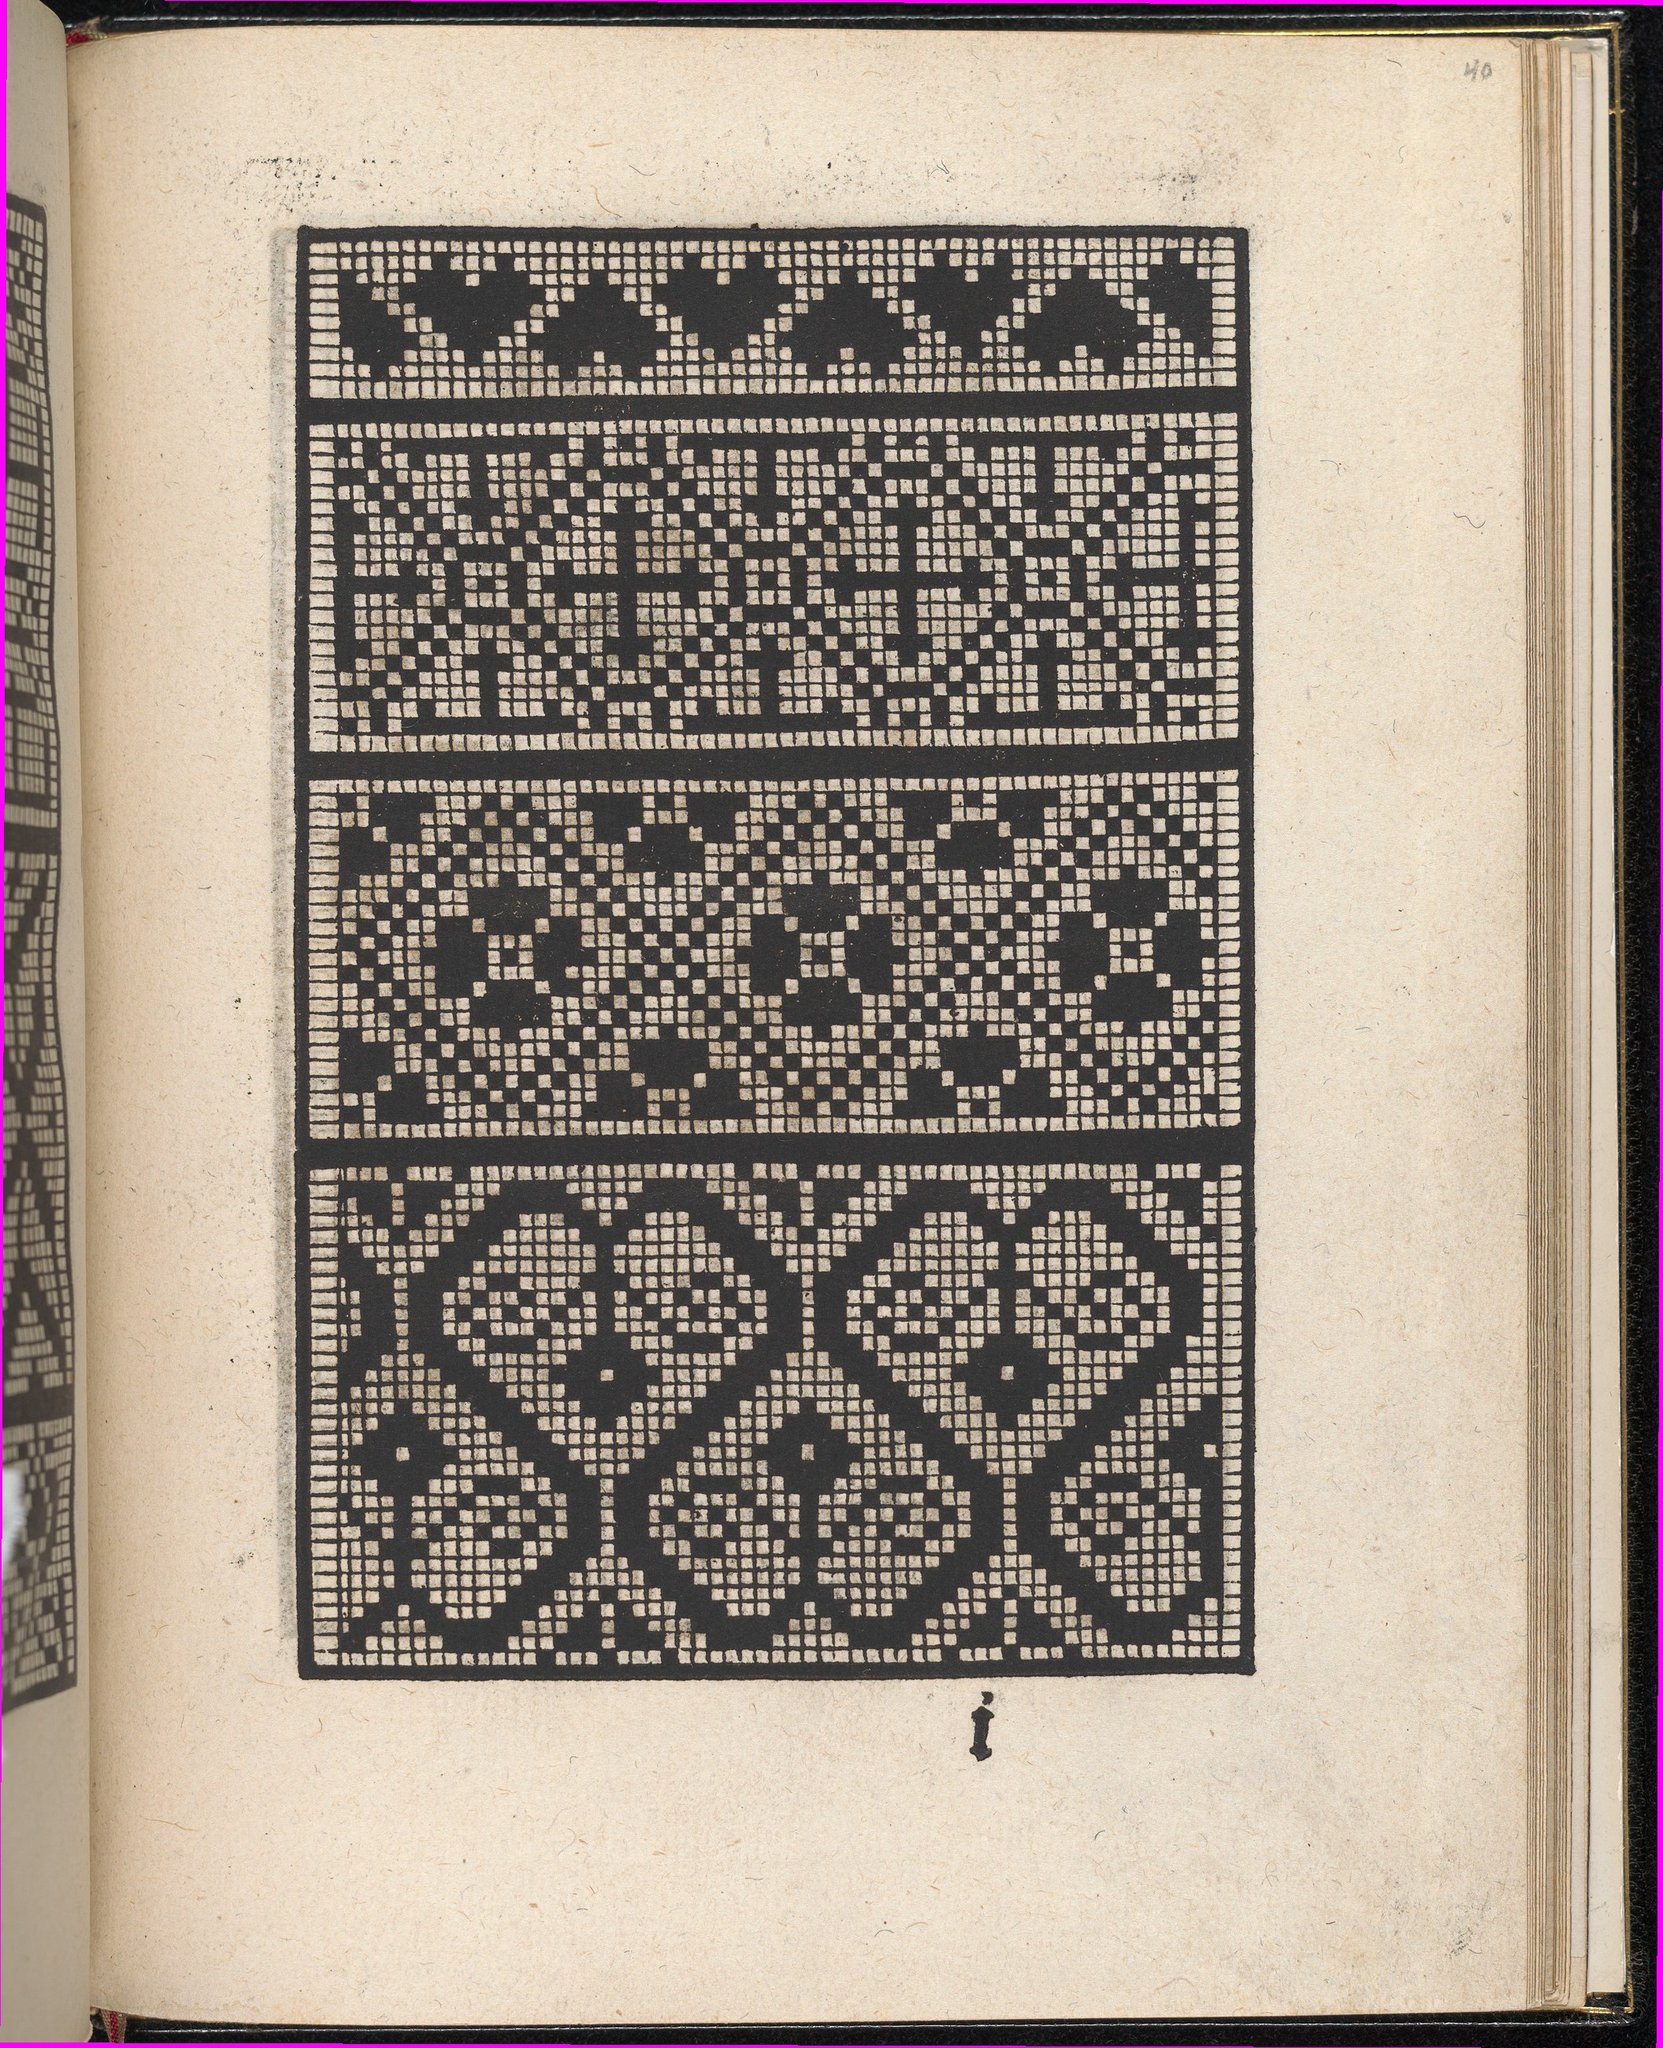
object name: book print ornament architecture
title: Page from Ein new kunstlich Modelbuch...(Page 40r)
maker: peter quentel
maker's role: publisher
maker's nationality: german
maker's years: 1500-1550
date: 1544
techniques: woodcut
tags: ornament